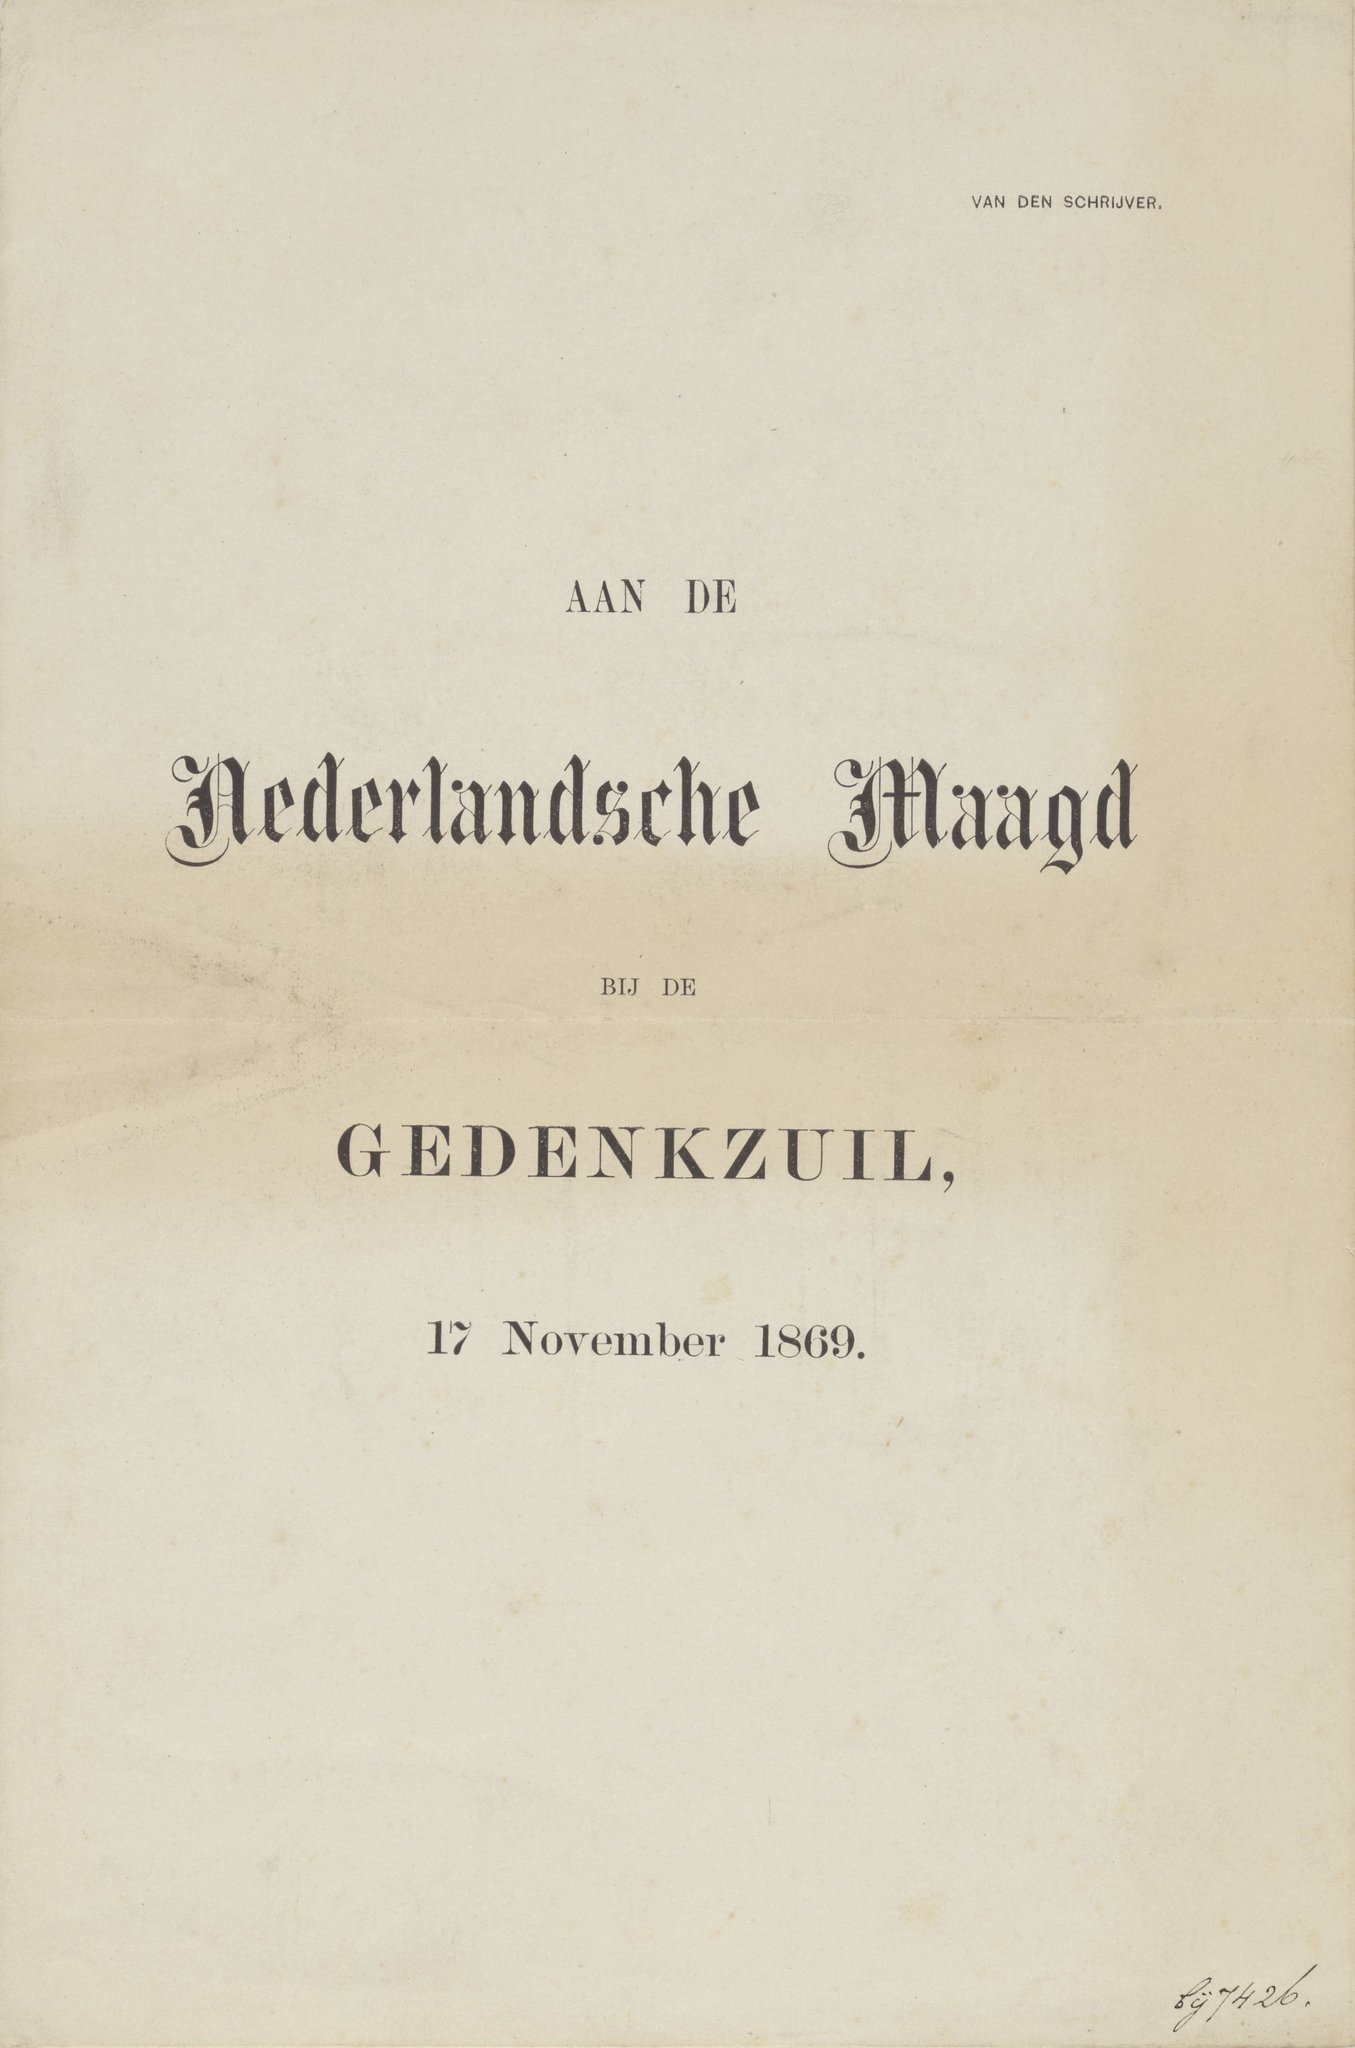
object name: text sheet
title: Aan de Nederlandsche Maagd bij de Gedenkzuil, 17 November 1869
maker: a. van stolk cz.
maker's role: schrijver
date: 1869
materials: paper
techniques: letterpress printing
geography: netherlands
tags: nationaal monument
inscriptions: collector's mark: Lugt 2228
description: Vers van drie coupletten van elk vier regels op de Nederlandse Maagd bij de onthulling op 17 november 1869 van het Nationaal Monument ter ere van koning Willem I en ter nagedachtenis aan 50 jaar onafhankelijkheid en de stichting van het Koninkrijk der Nederlanden in 1813, in het Willemspark (nu Plein 1813) te Den Haag. Behoort bij de prent van monument.